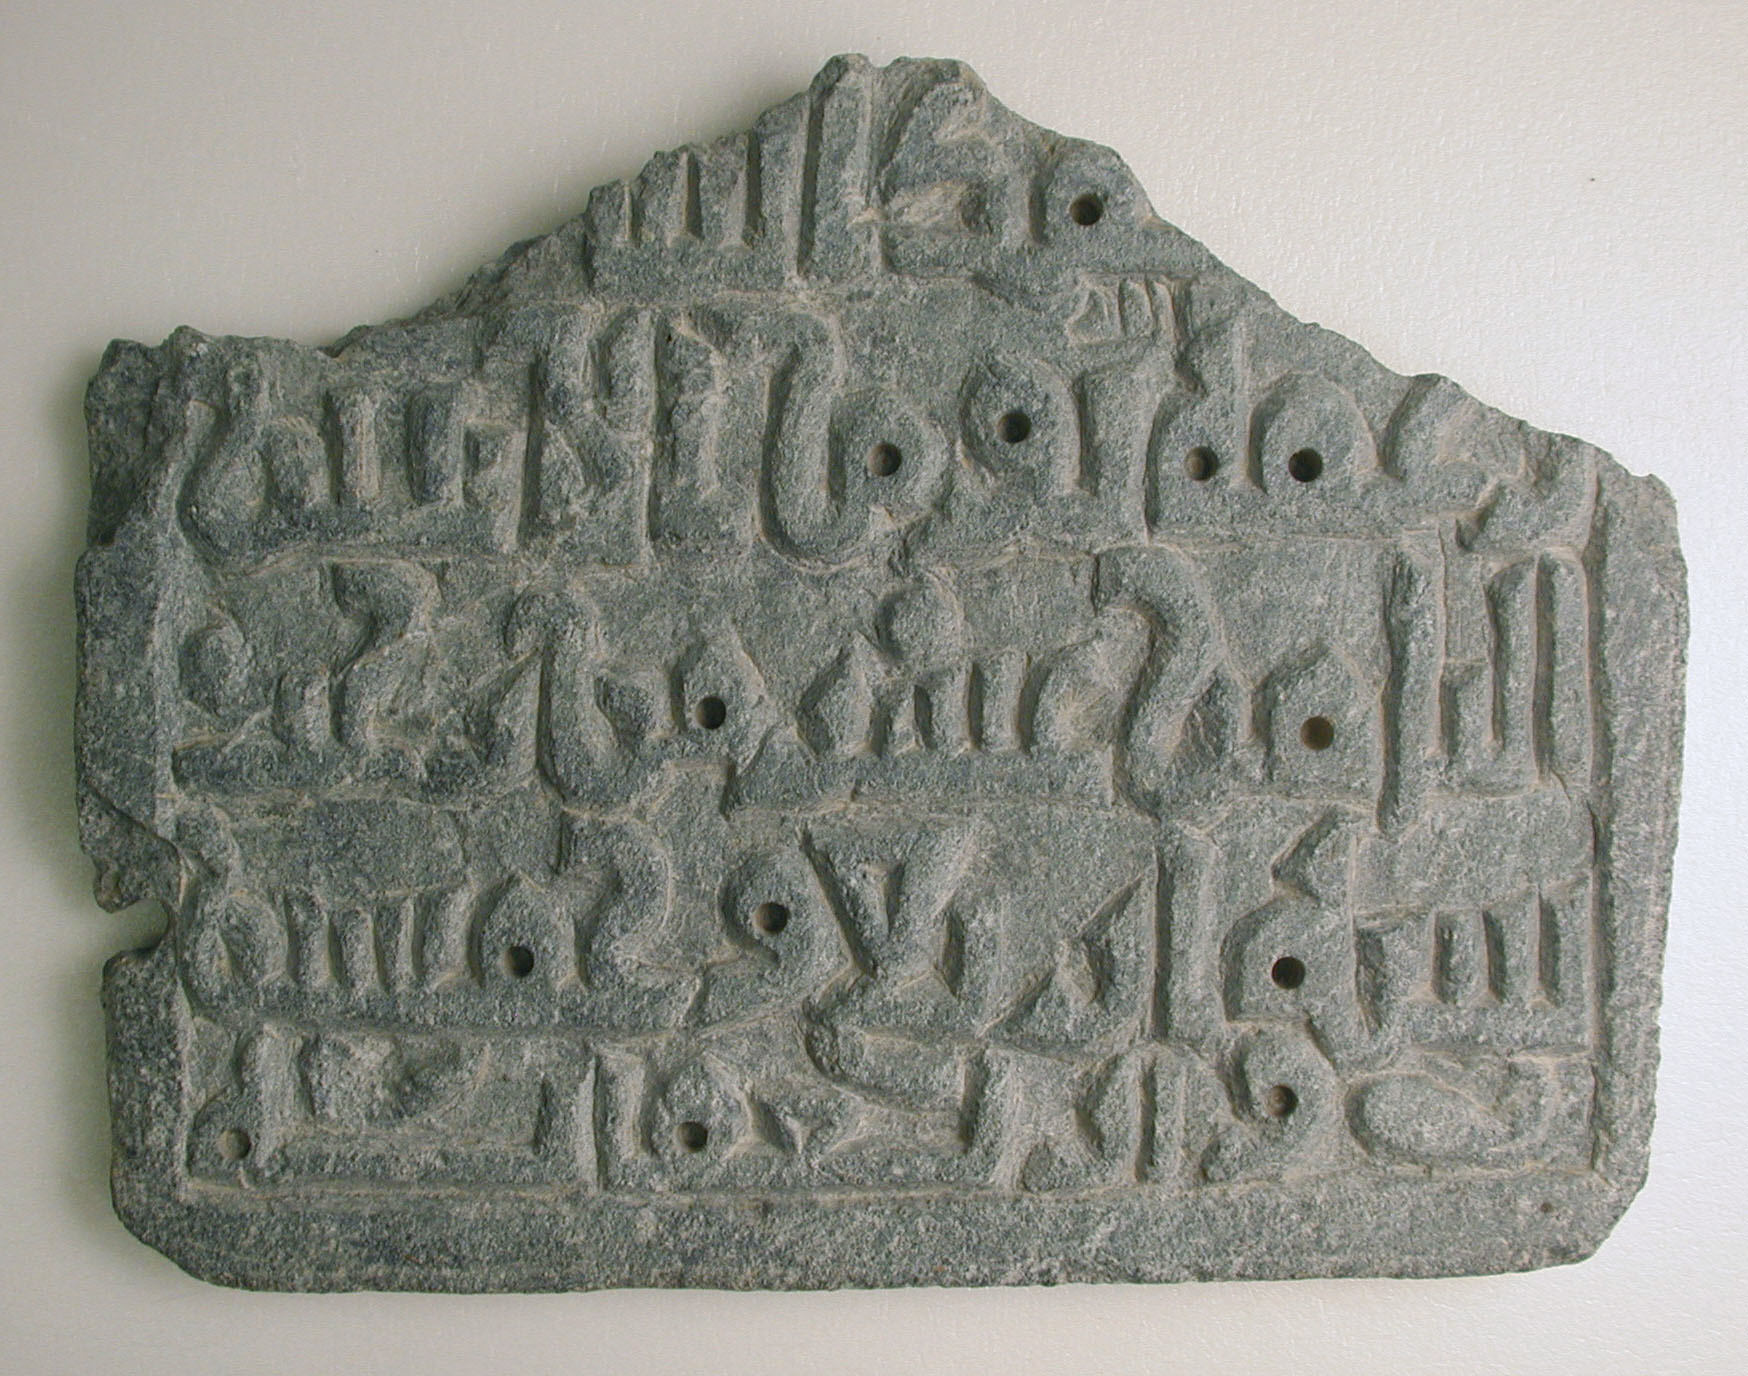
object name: stele fragment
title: Gravestone Dated 1062, Reused in 1128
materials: stone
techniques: carving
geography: iran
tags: arabic